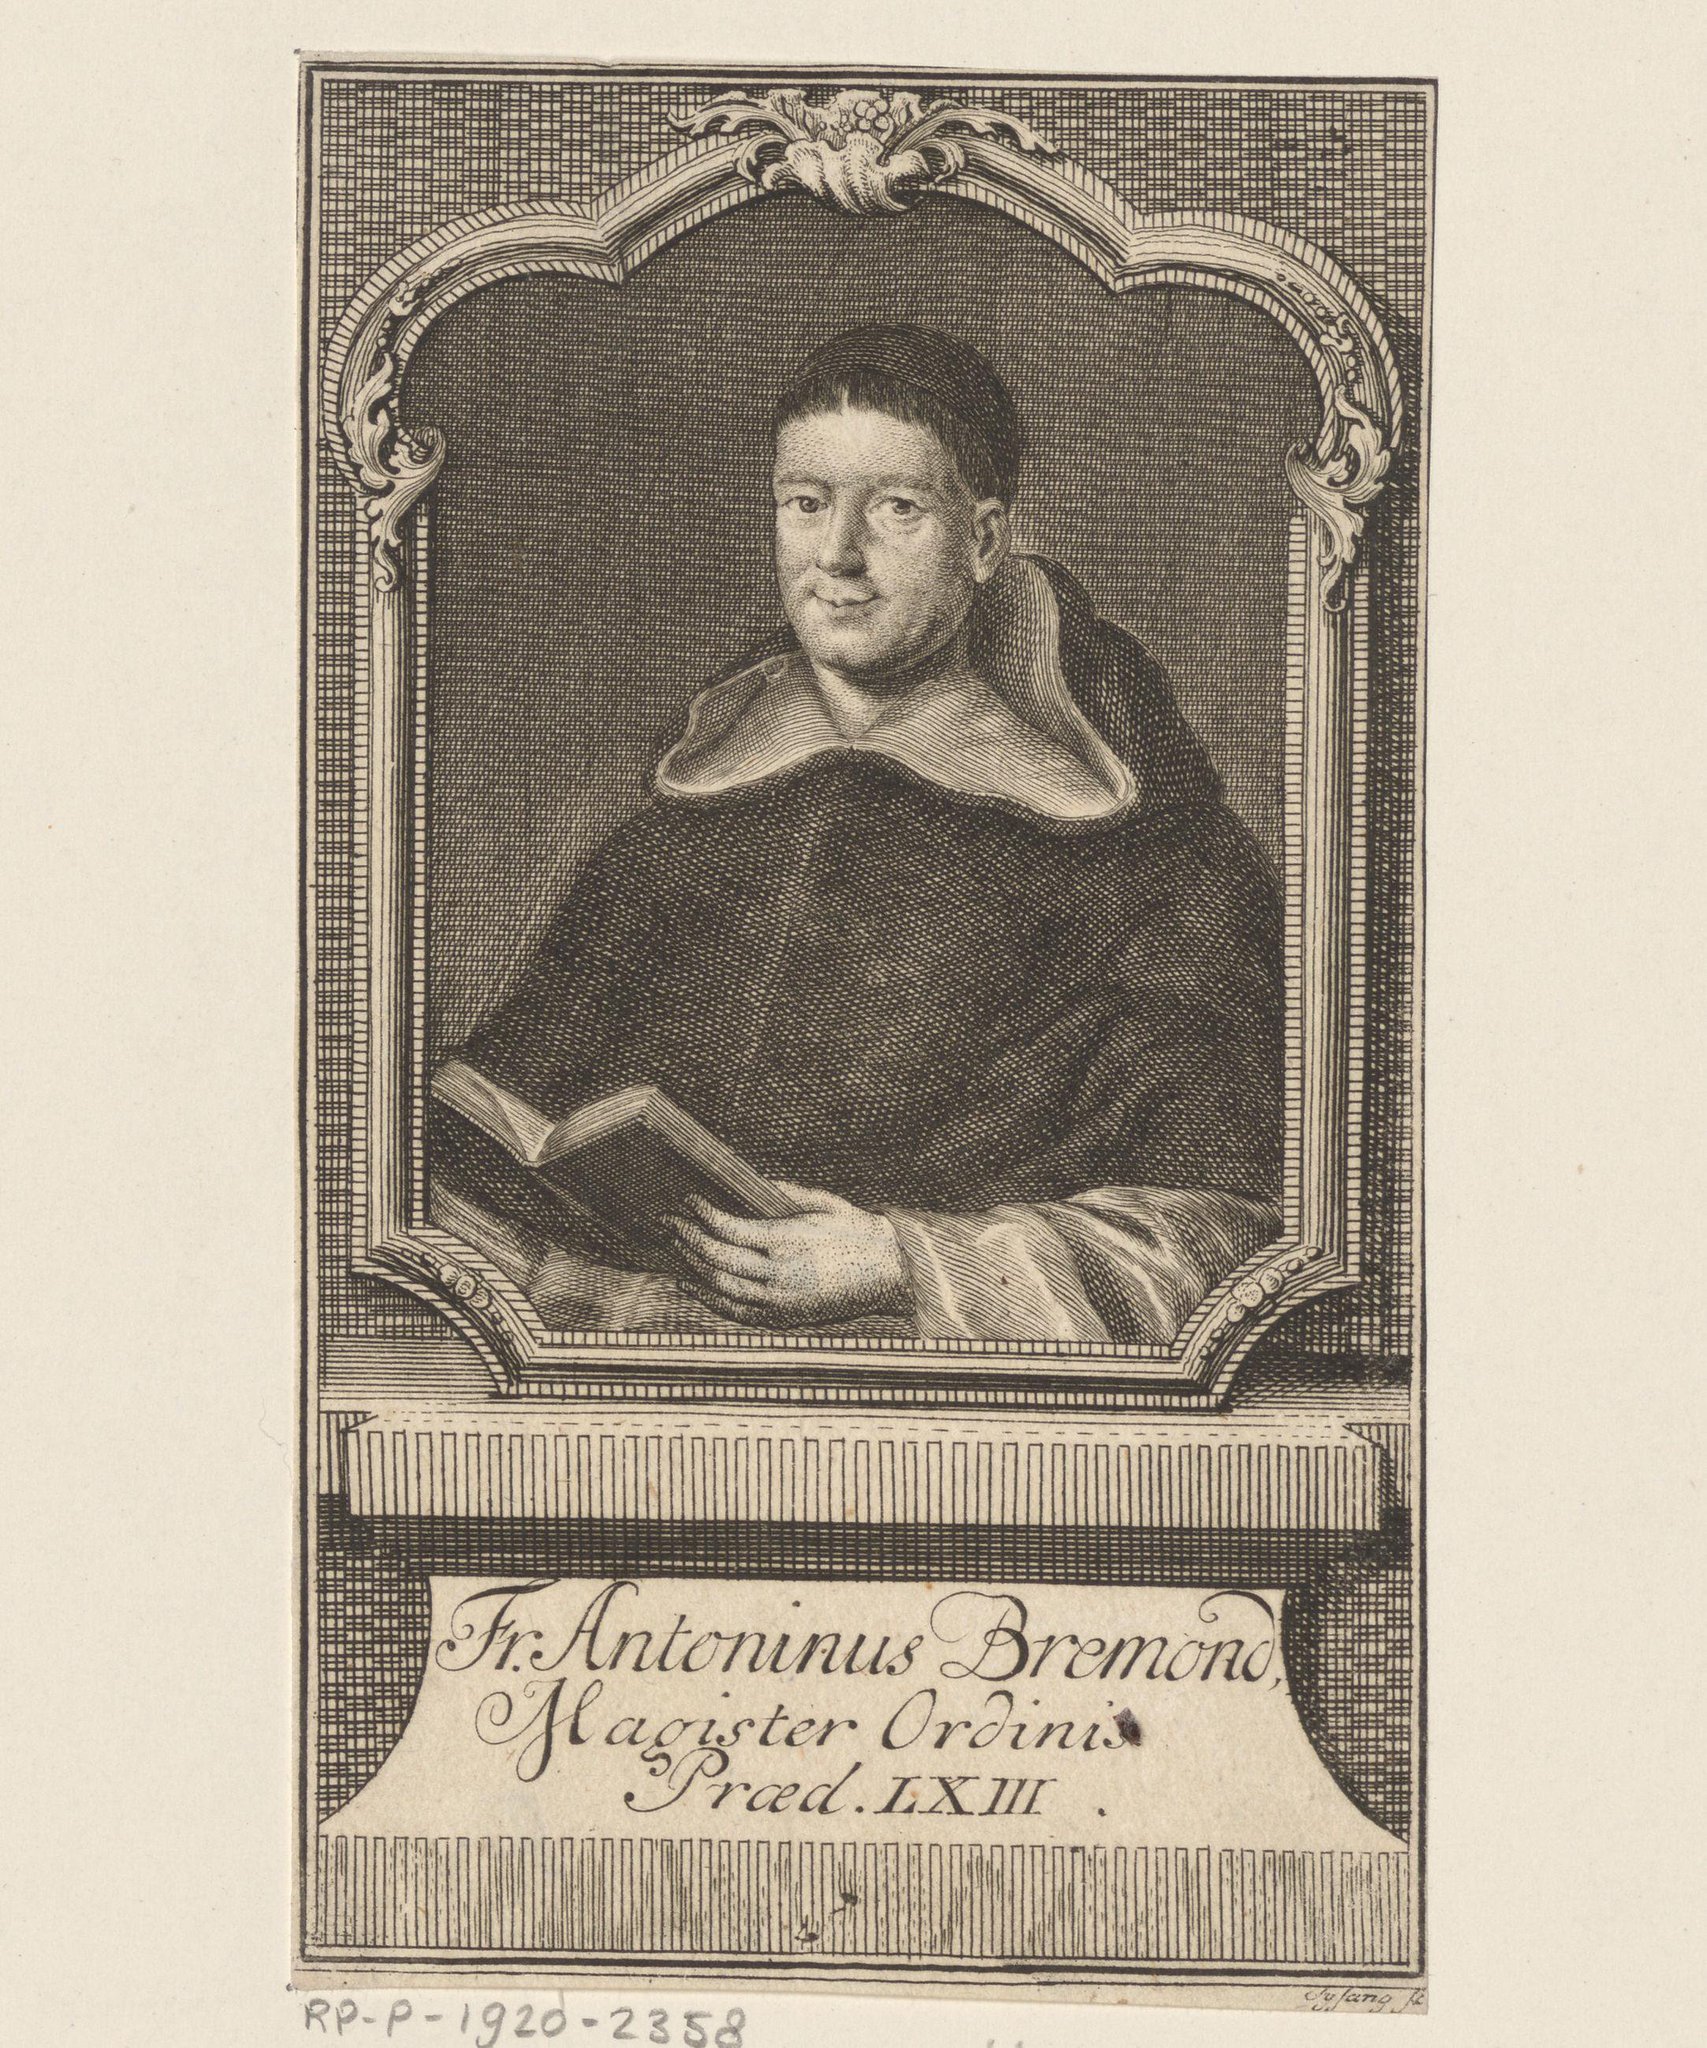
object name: print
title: Portret van Antonin Brémond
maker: johann christoph sysang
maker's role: print maker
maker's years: 1703-1757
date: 1713-1757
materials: paper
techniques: engraving, etching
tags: theologian, historical persons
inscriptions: collector's mark: Lugt 2228